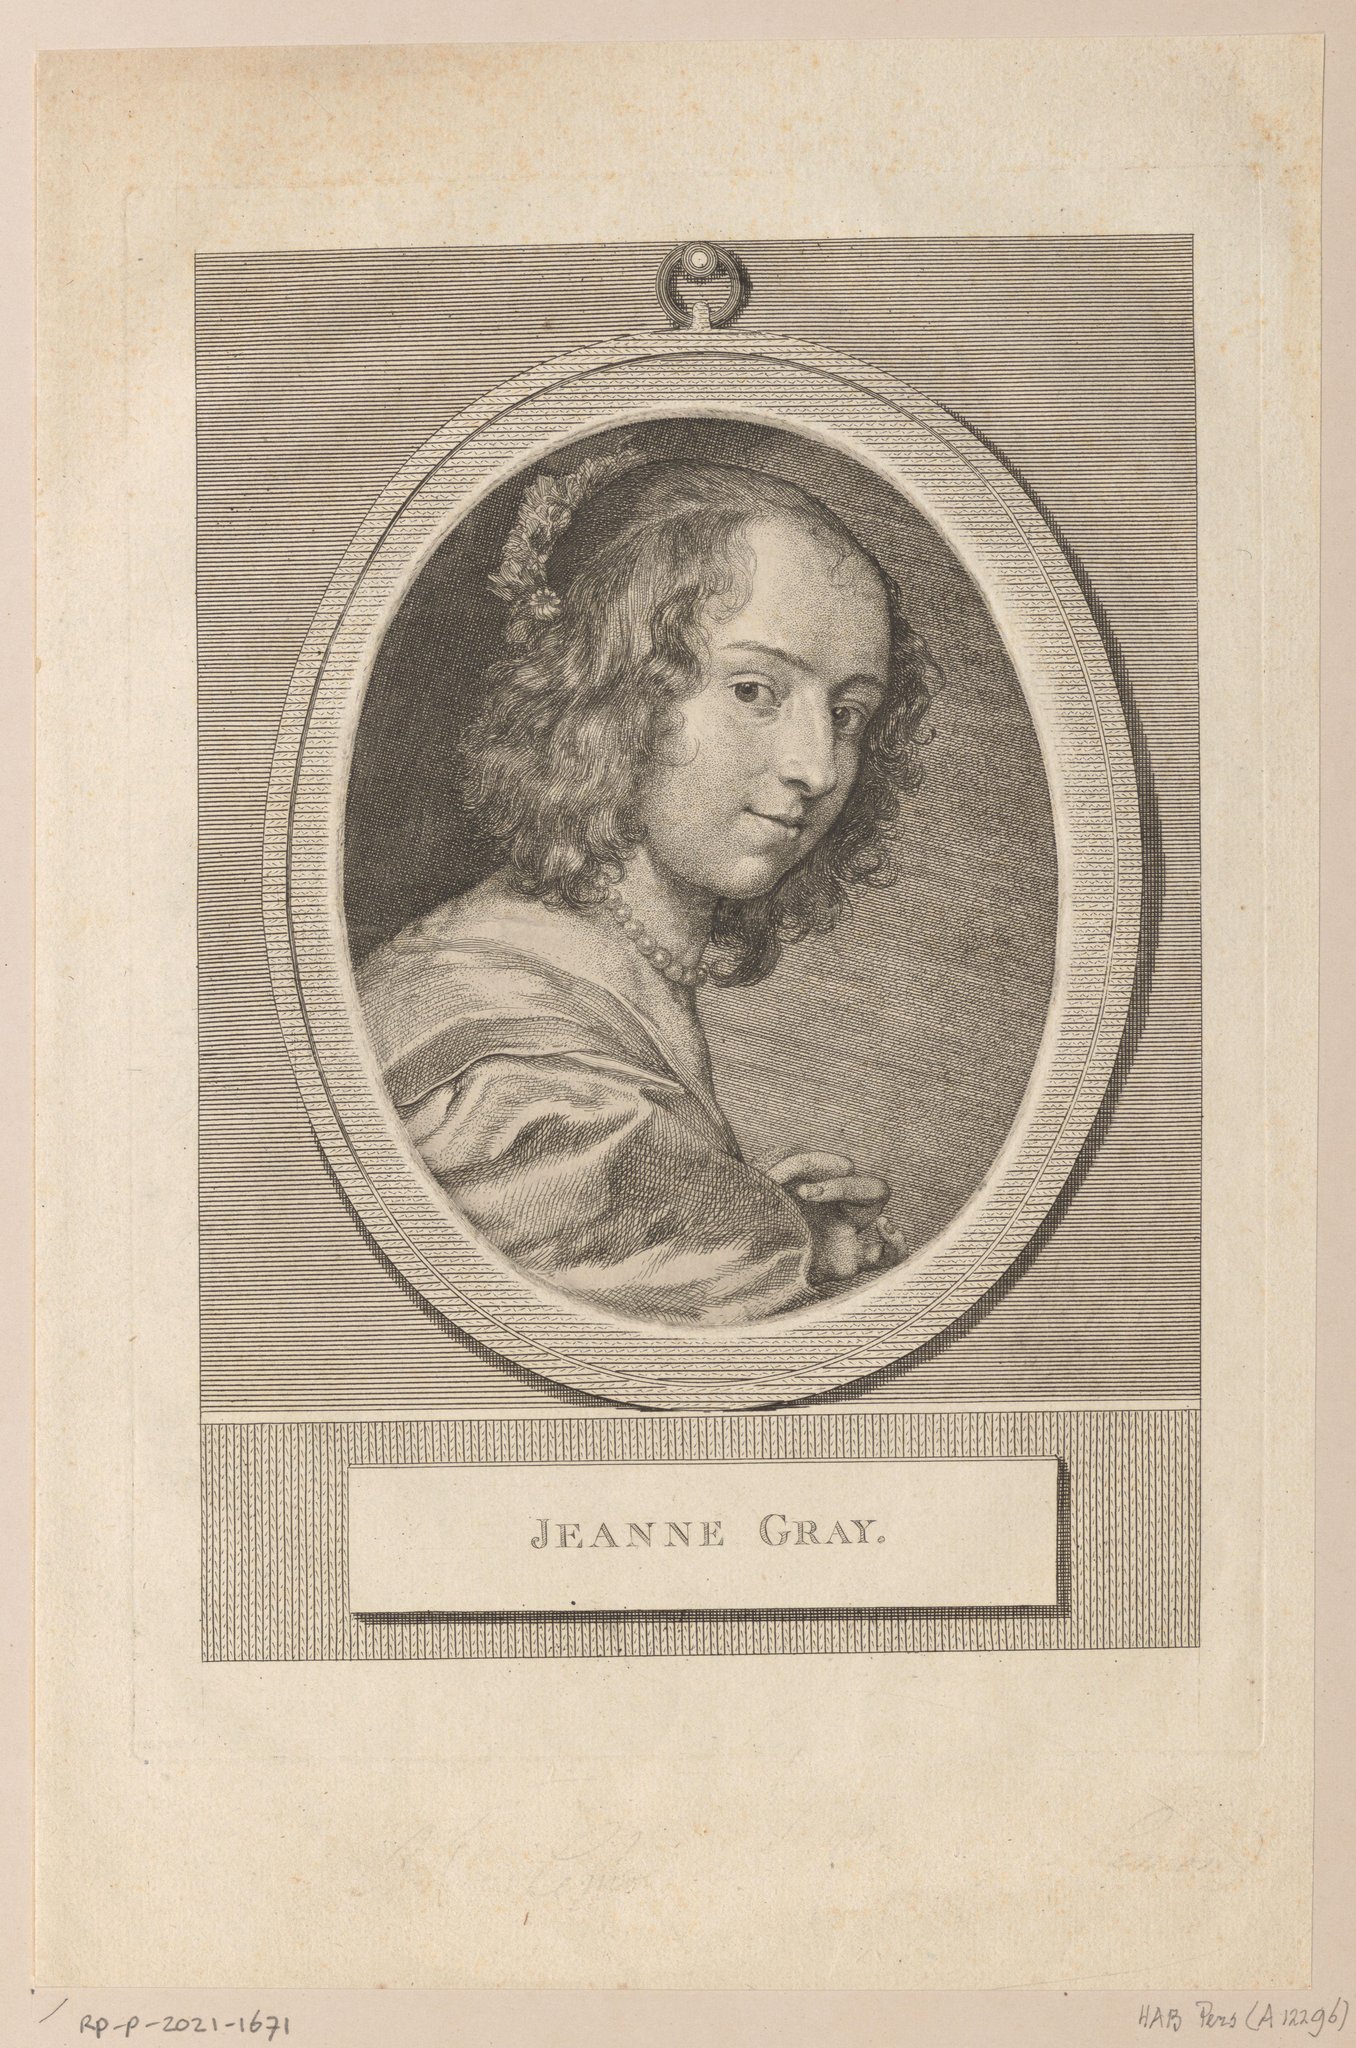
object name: print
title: Portret van Ninon de Lenclos als Jane Grey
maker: Anonymous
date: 1650-1720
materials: paper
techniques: engraving, etching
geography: france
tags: paris, historical persons - bb - woman, ornament ~ medallion, pearl; pearl necklace